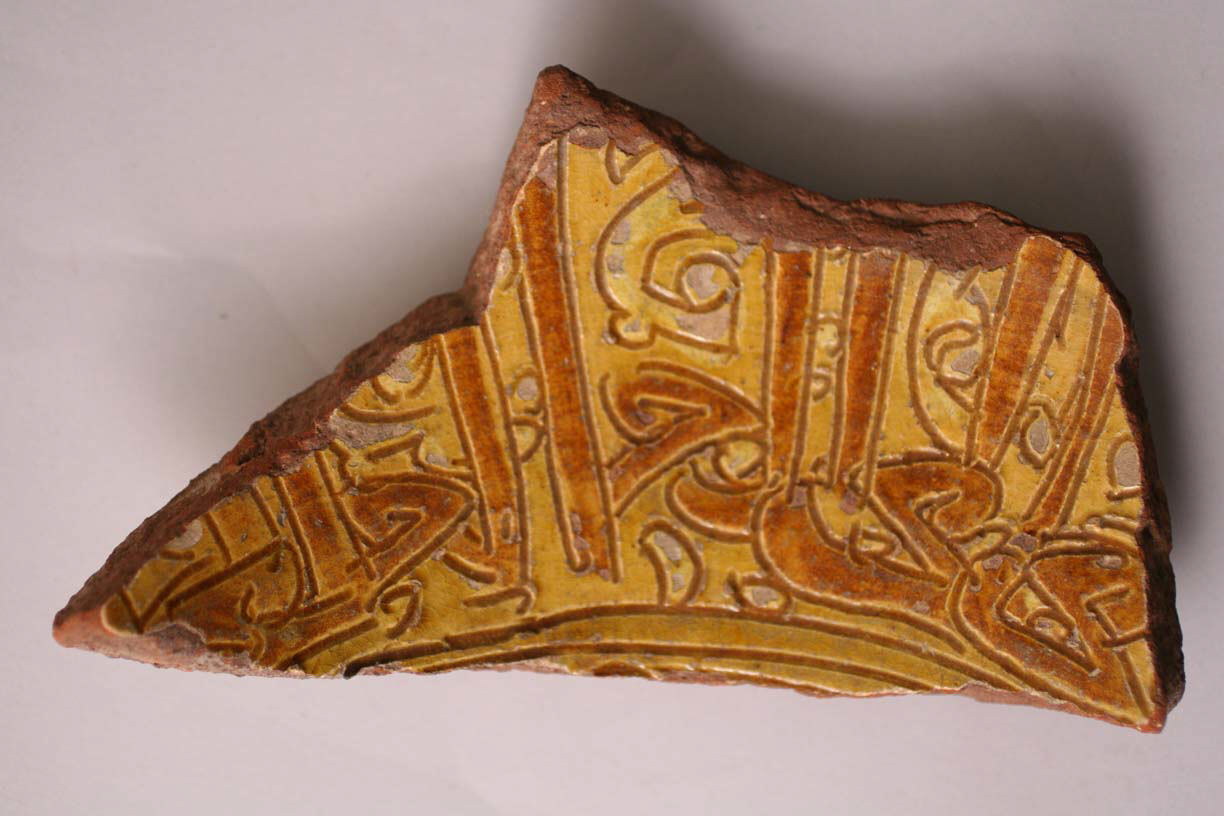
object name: ceramic fragment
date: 1301-1500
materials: earthenware, glaze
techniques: coloring, incising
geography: egypt